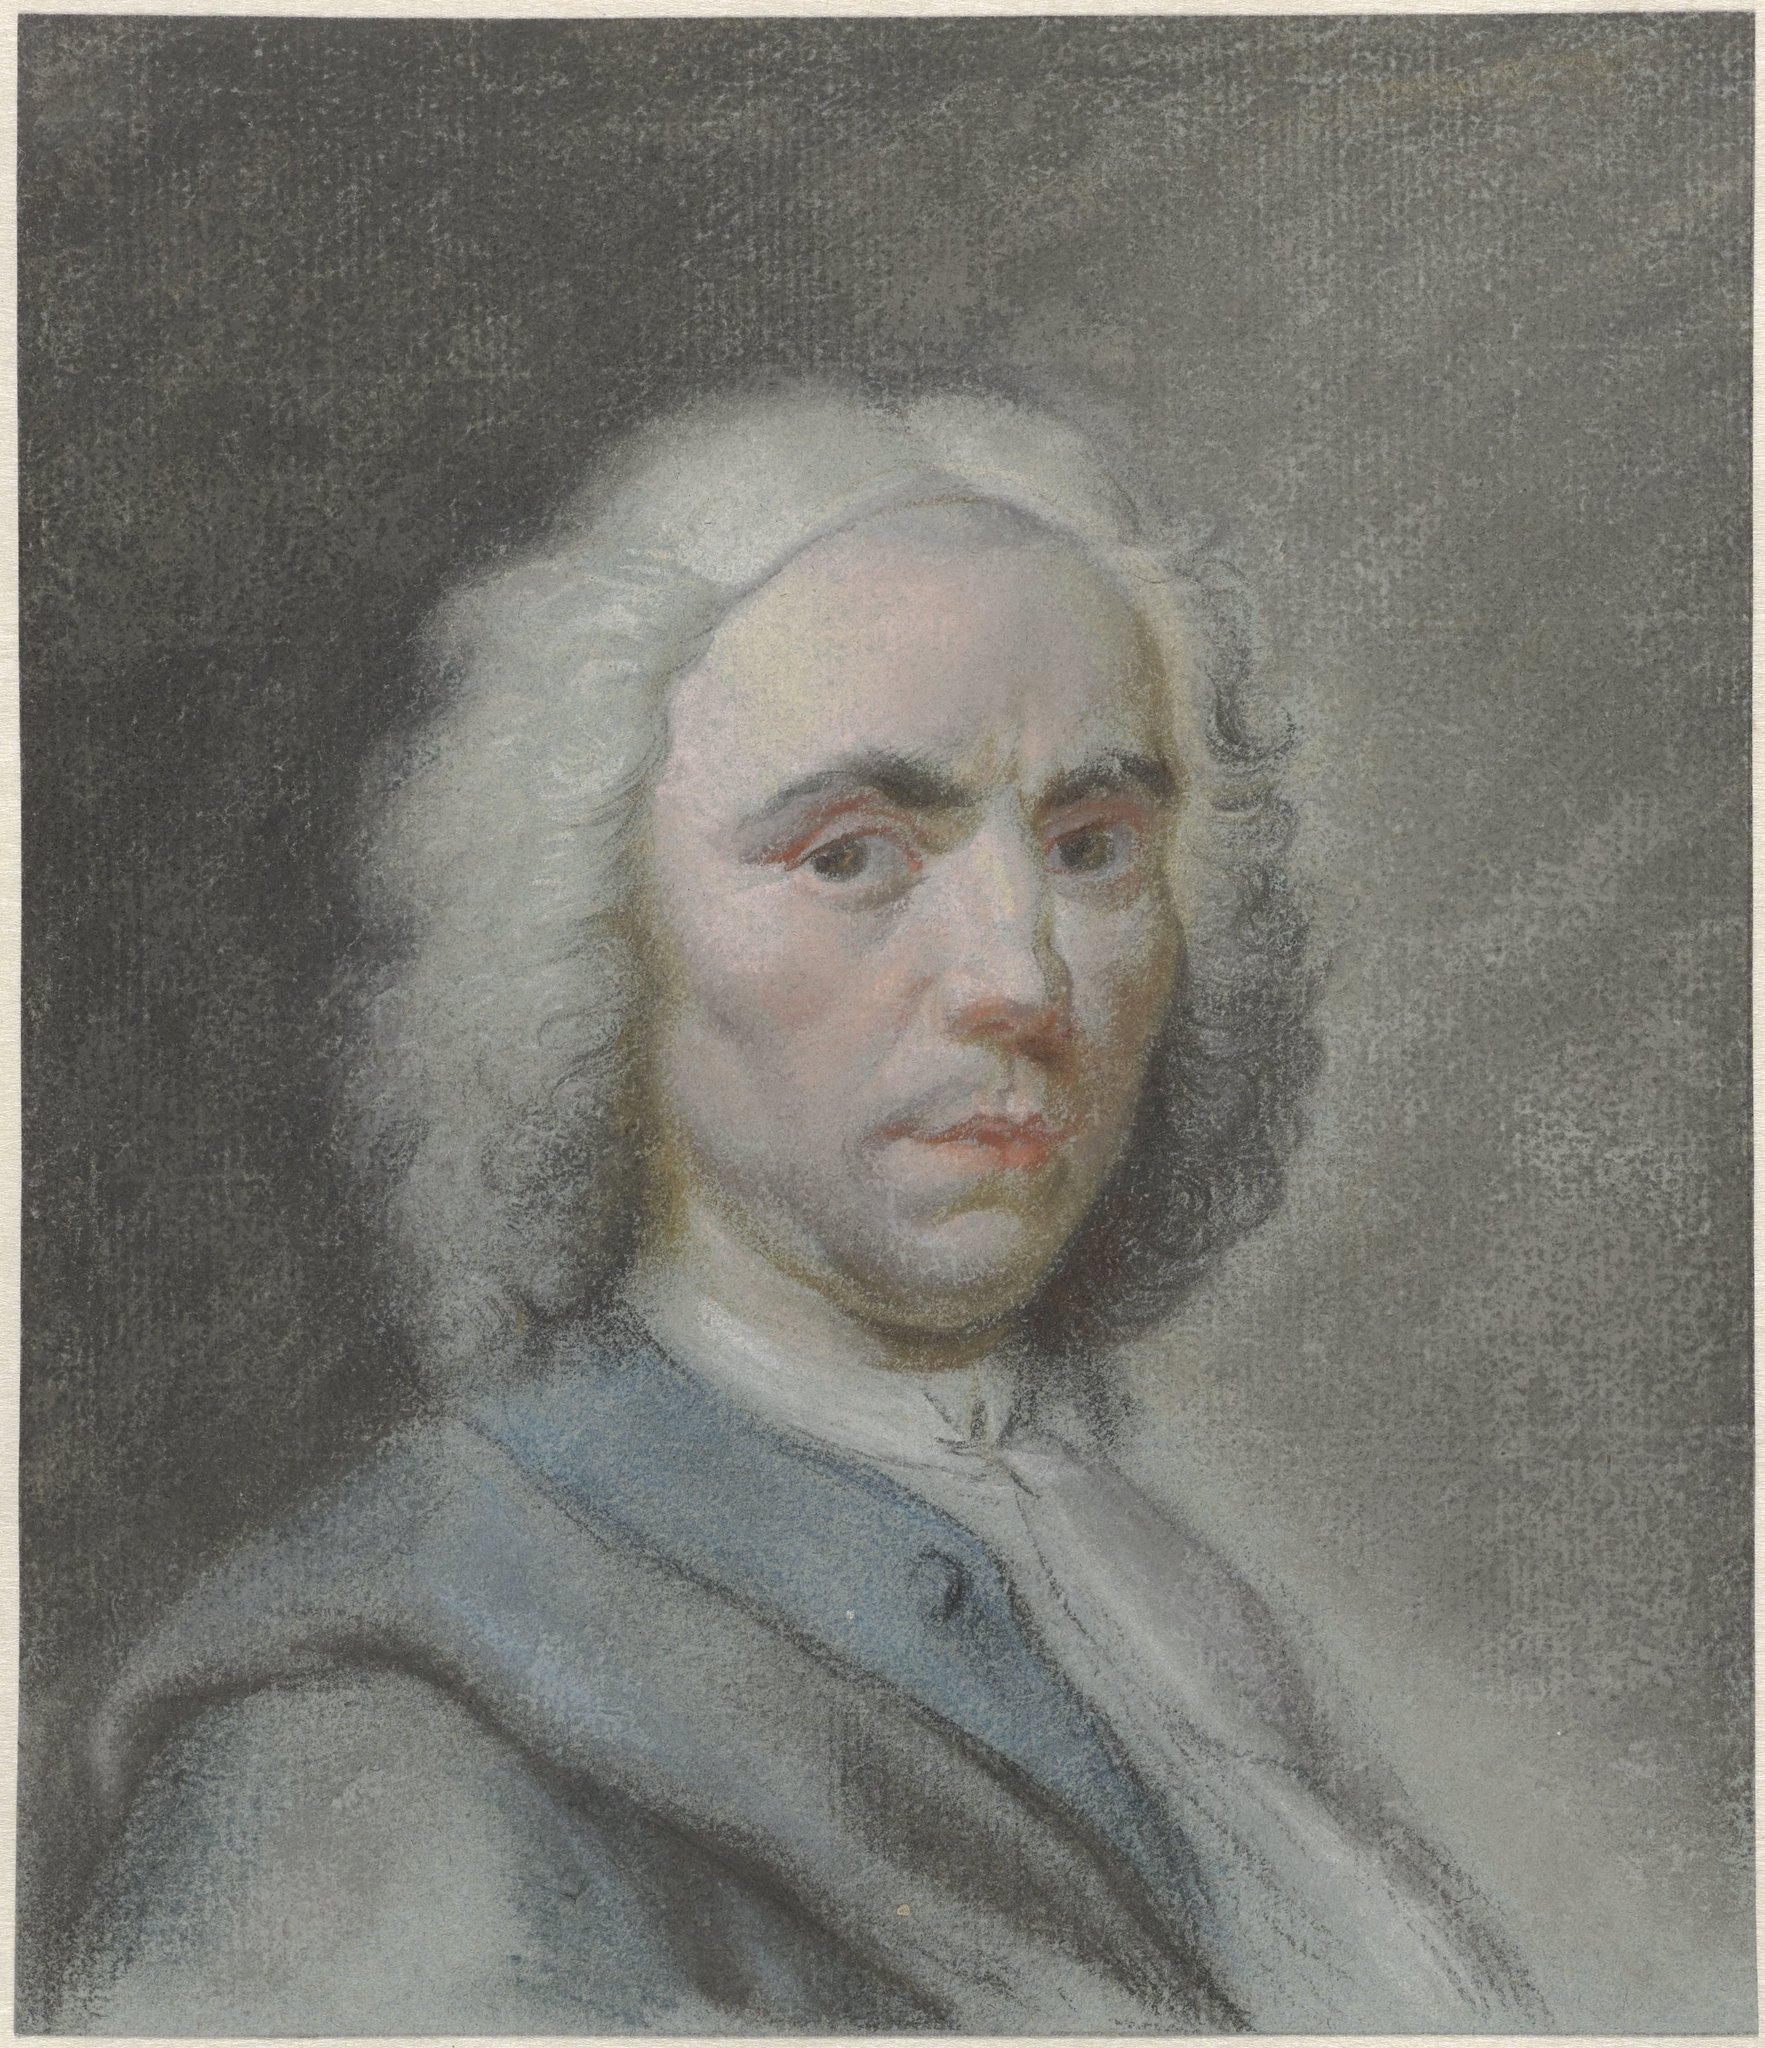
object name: drawing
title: Zelfportret van Louis de Moni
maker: louis de moni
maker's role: draughtsman, painter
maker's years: 1698-1771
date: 1772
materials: chalk, paper, pastel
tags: leiden, painter, draughtsman, louis de moni, historical persons, portrait, self-portrait of artist